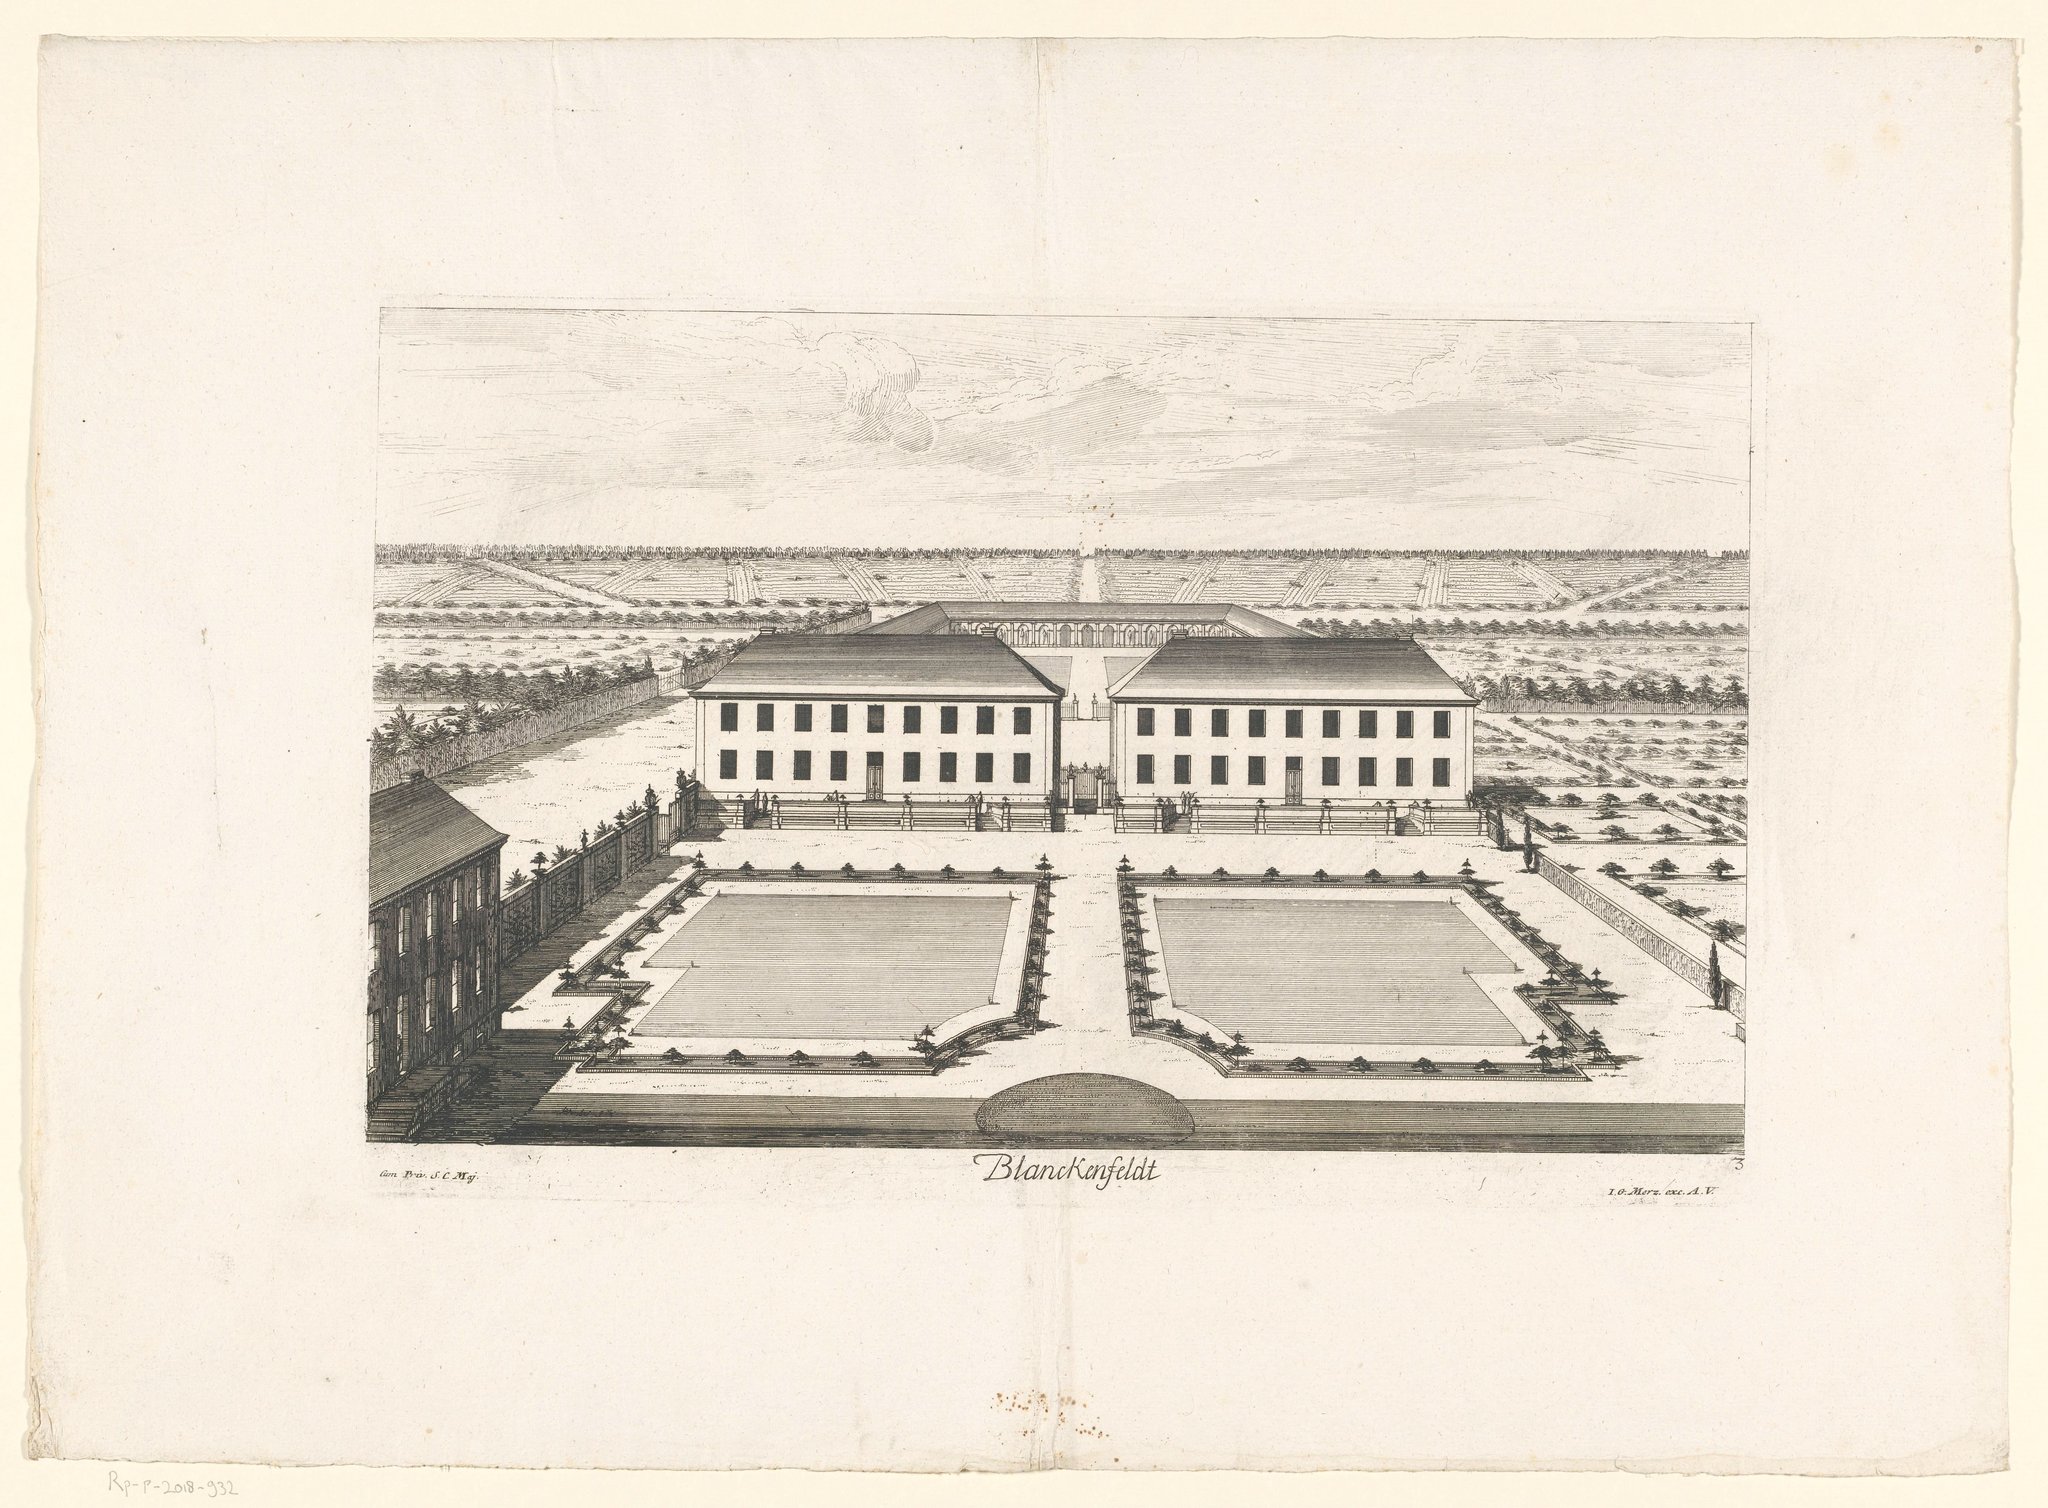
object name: book illustration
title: Blanckenfeldt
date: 1733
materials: paper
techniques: etching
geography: augsburg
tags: palace, berlin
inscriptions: collector's mark: Lugt 2228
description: Prent gebruikt in: Broesbes, Jean-Baptiste. Vues des Palais et Maisons de Plaisance de Sa Majesté le Roy de Prusse. Augsburg: Johann Georg Merz, 1733.